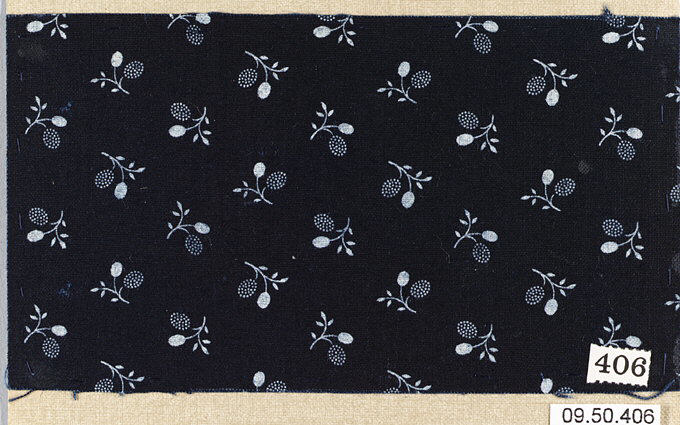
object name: piece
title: Piece (one of 116)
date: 1801-1900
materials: cotton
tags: leaves